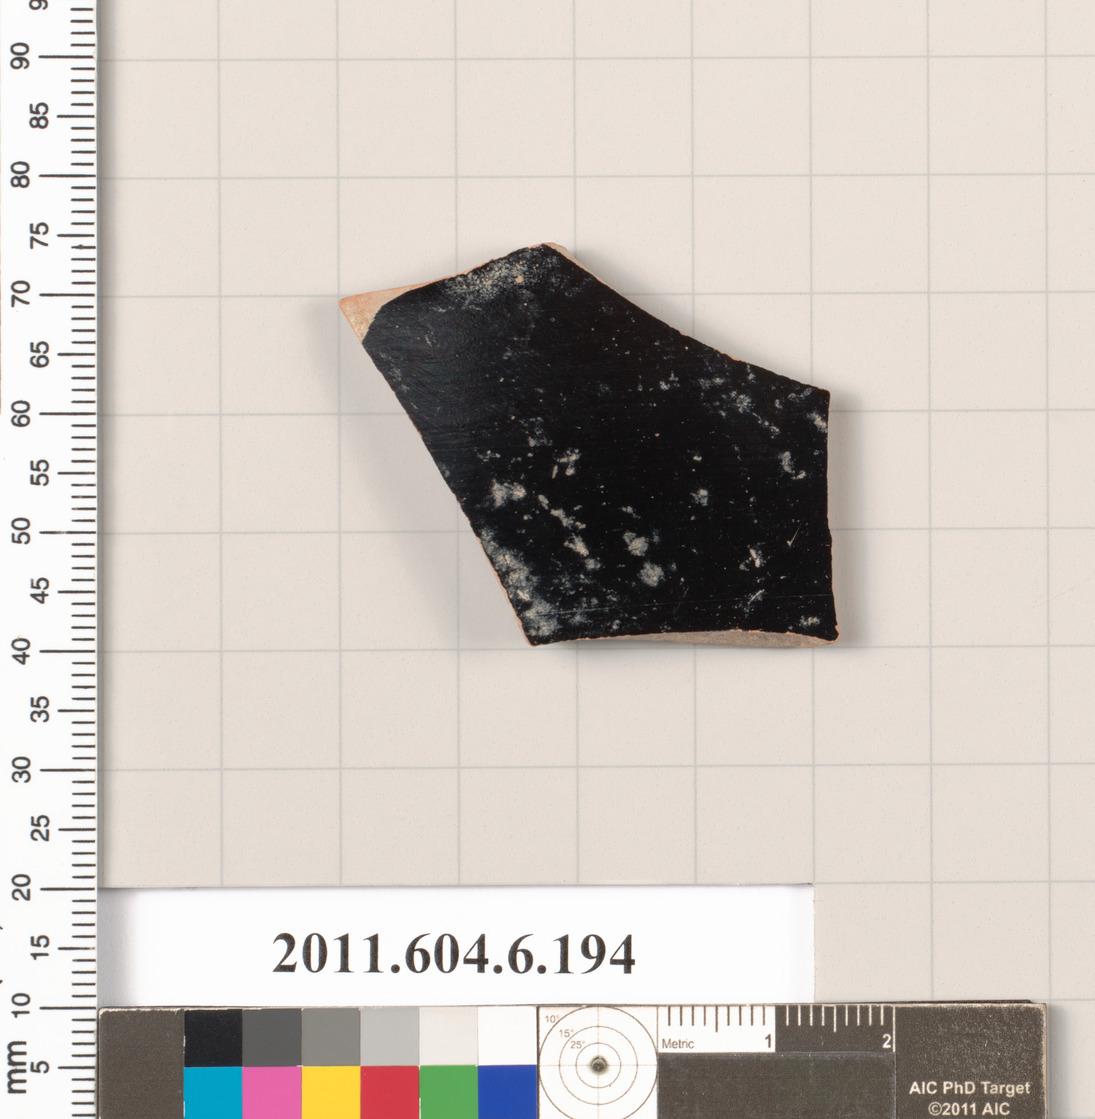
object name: skyphos fragment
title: Terracotta fragment of a skyphos (deep drinking cup)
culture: greek, attic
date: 500-401 BCE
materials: terracotta